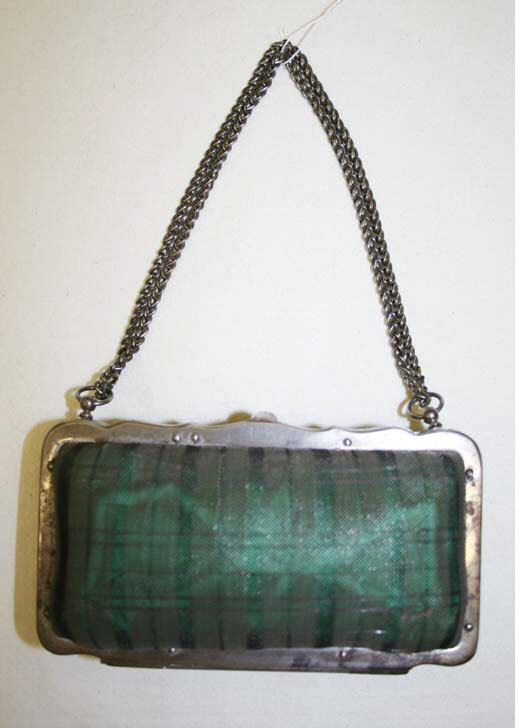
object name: purse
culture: american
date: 1800-1850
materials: metal, silk